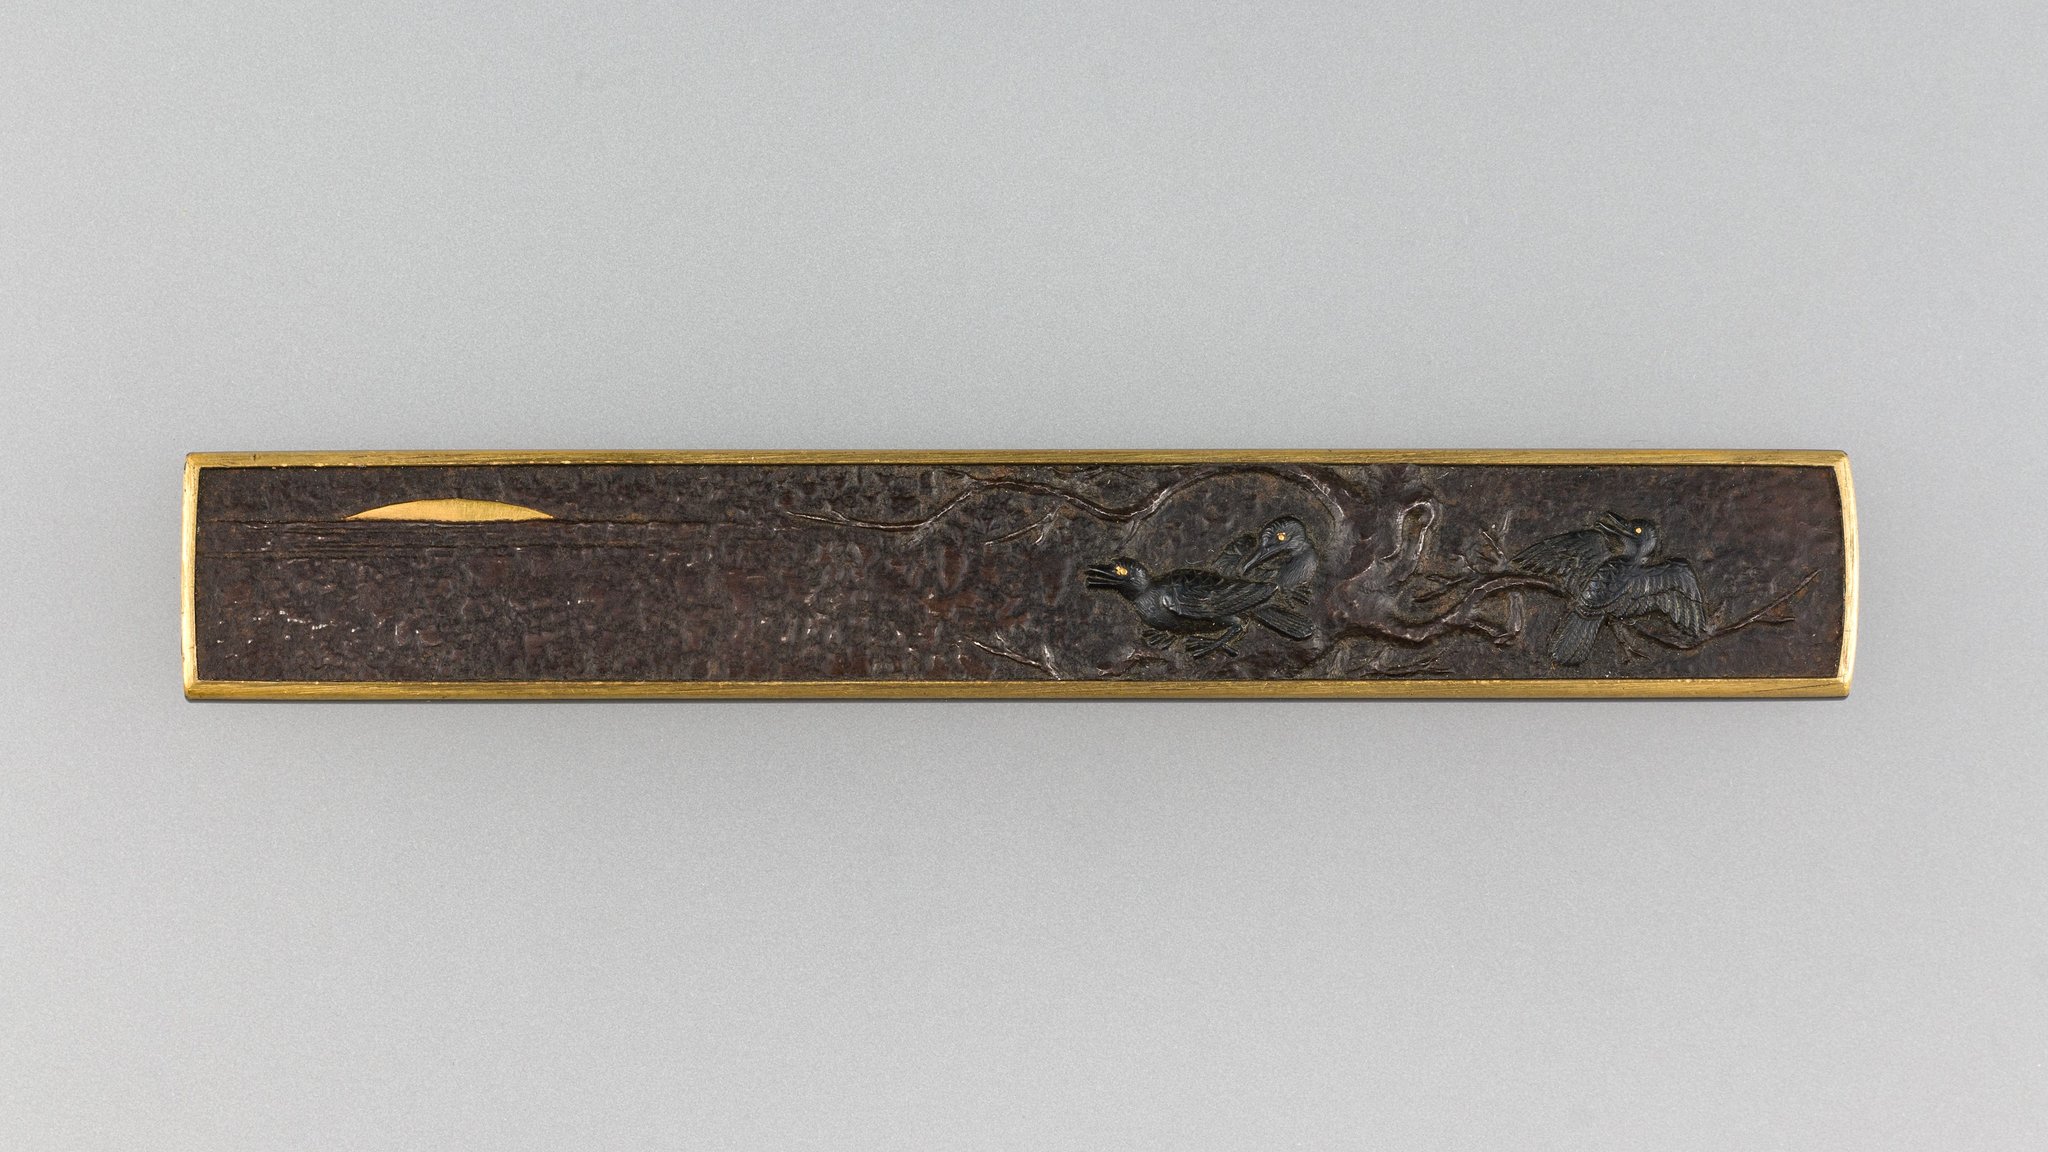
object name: knife handle kozuka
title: Knife Handle (Kozuka)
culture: japanese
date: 1801-1850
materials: silver alloy, gold, iron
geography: japan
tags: birds